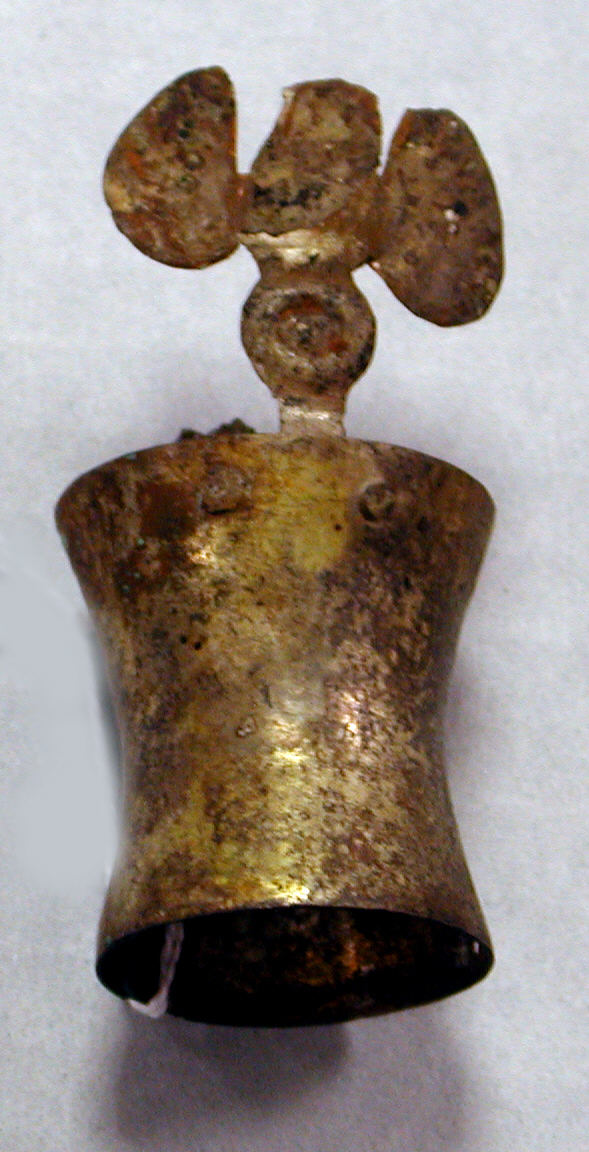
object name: crown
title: Hammered Silver Miniature Crown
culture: peruvian, north or central coast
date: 1001-1566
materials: gilt, silver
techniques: hammering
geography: peru